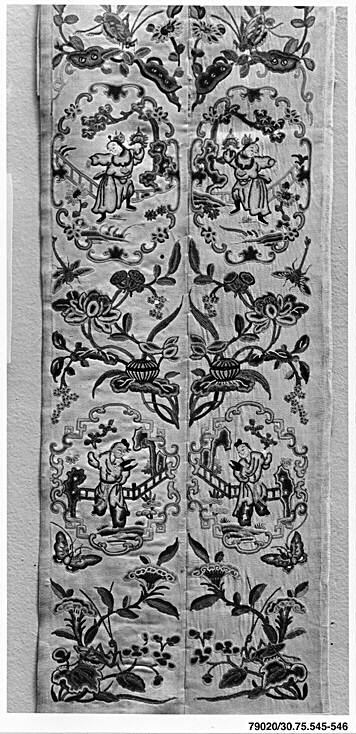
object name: sleeve band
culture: chinese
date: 1801-1900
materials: metal thread, silk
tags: human figures,dragonflies,flowers